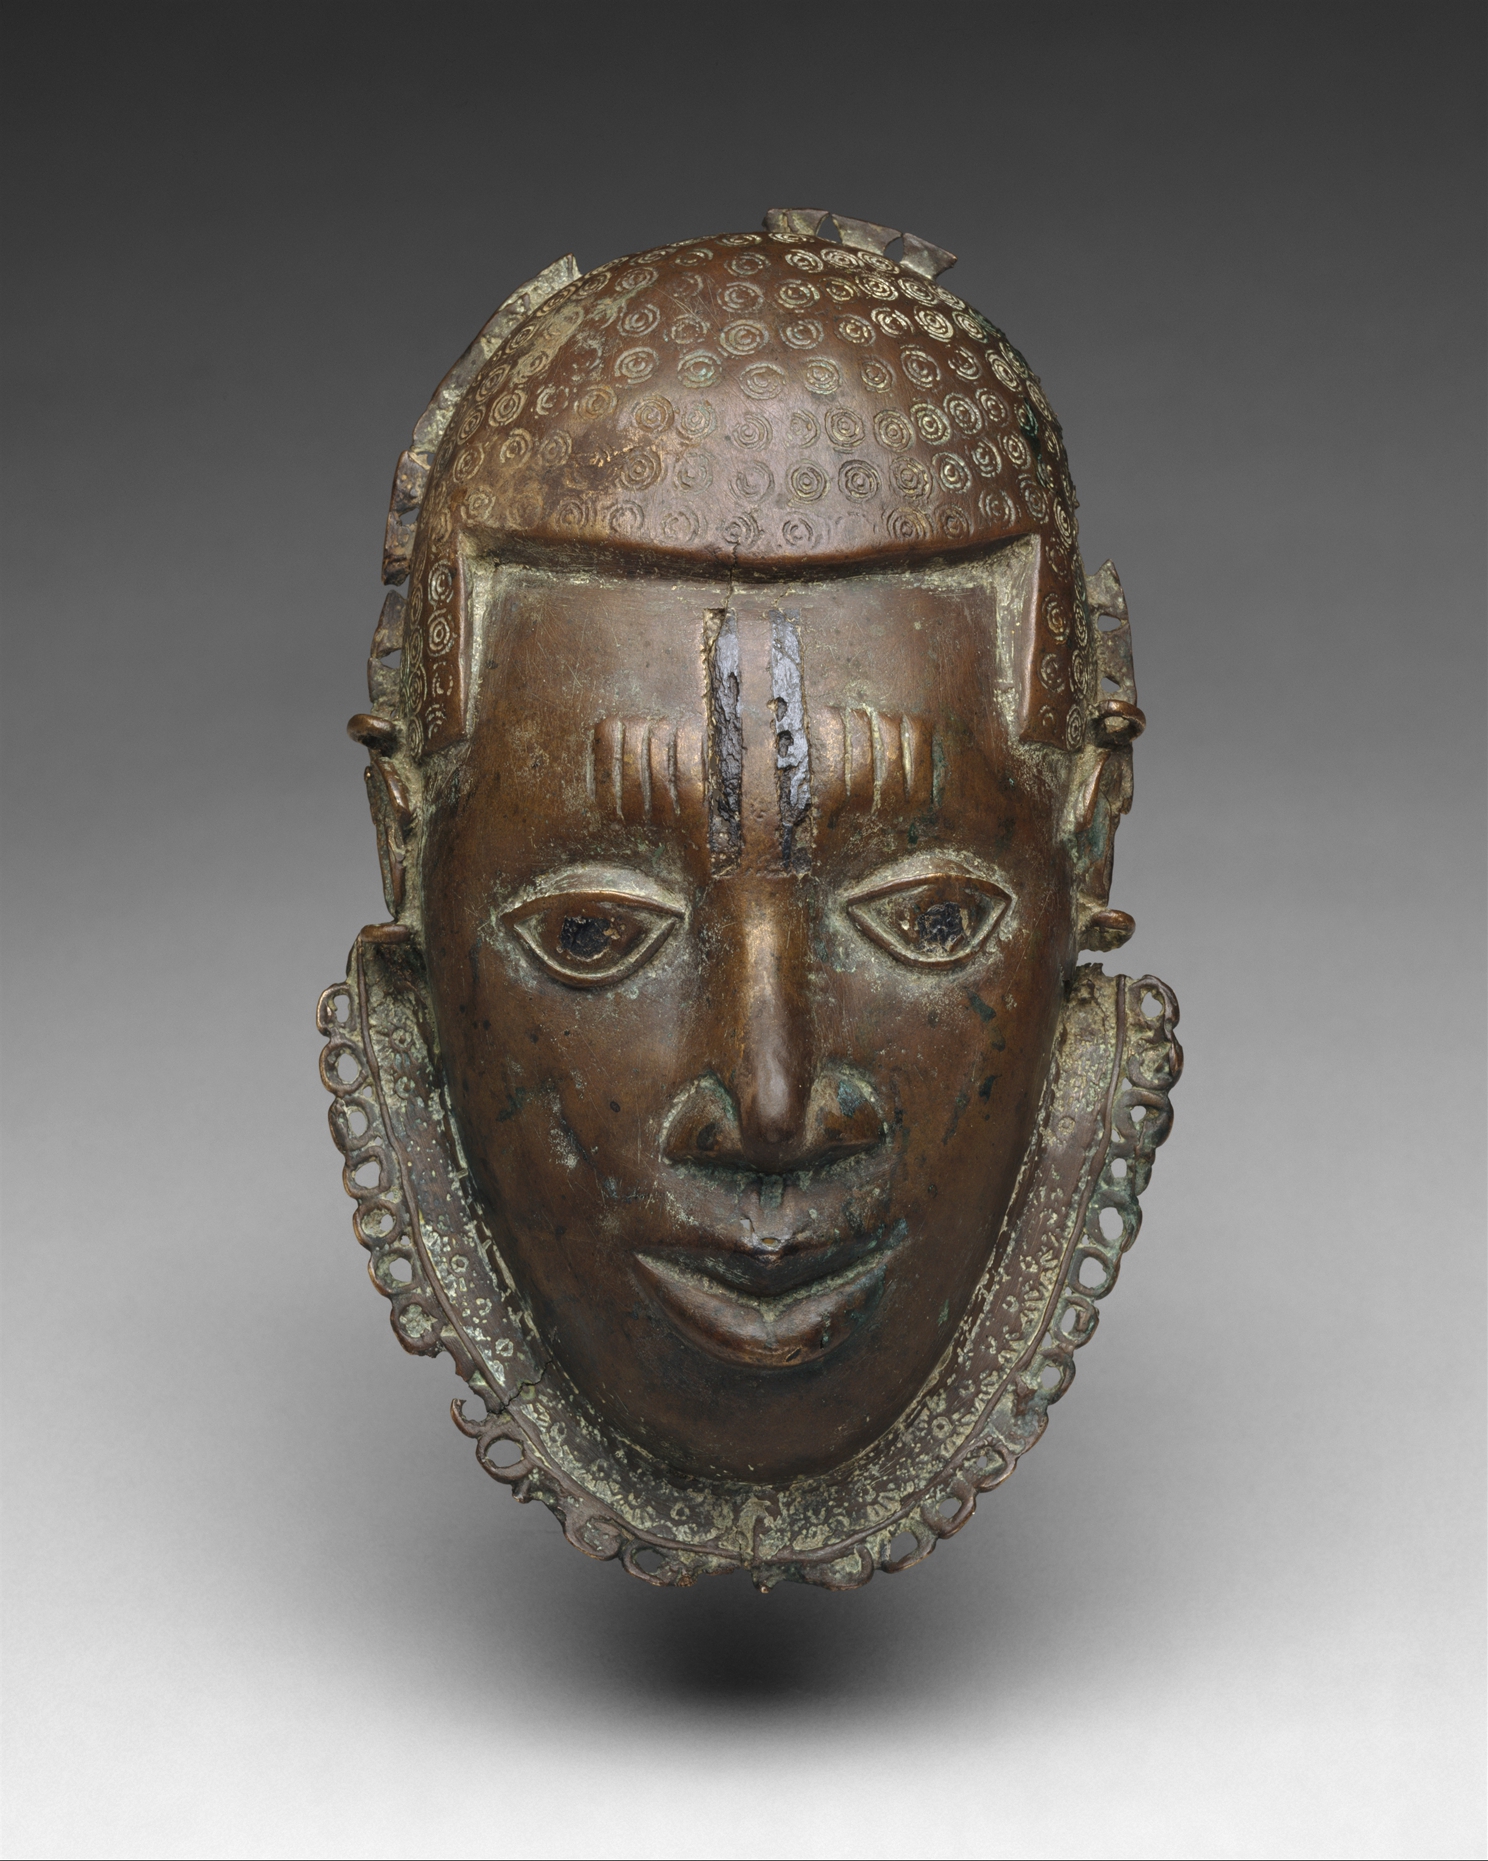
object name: ornament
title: Pectoral: Face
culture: edo period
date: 1401-1700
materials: brass, iron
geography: nigeria